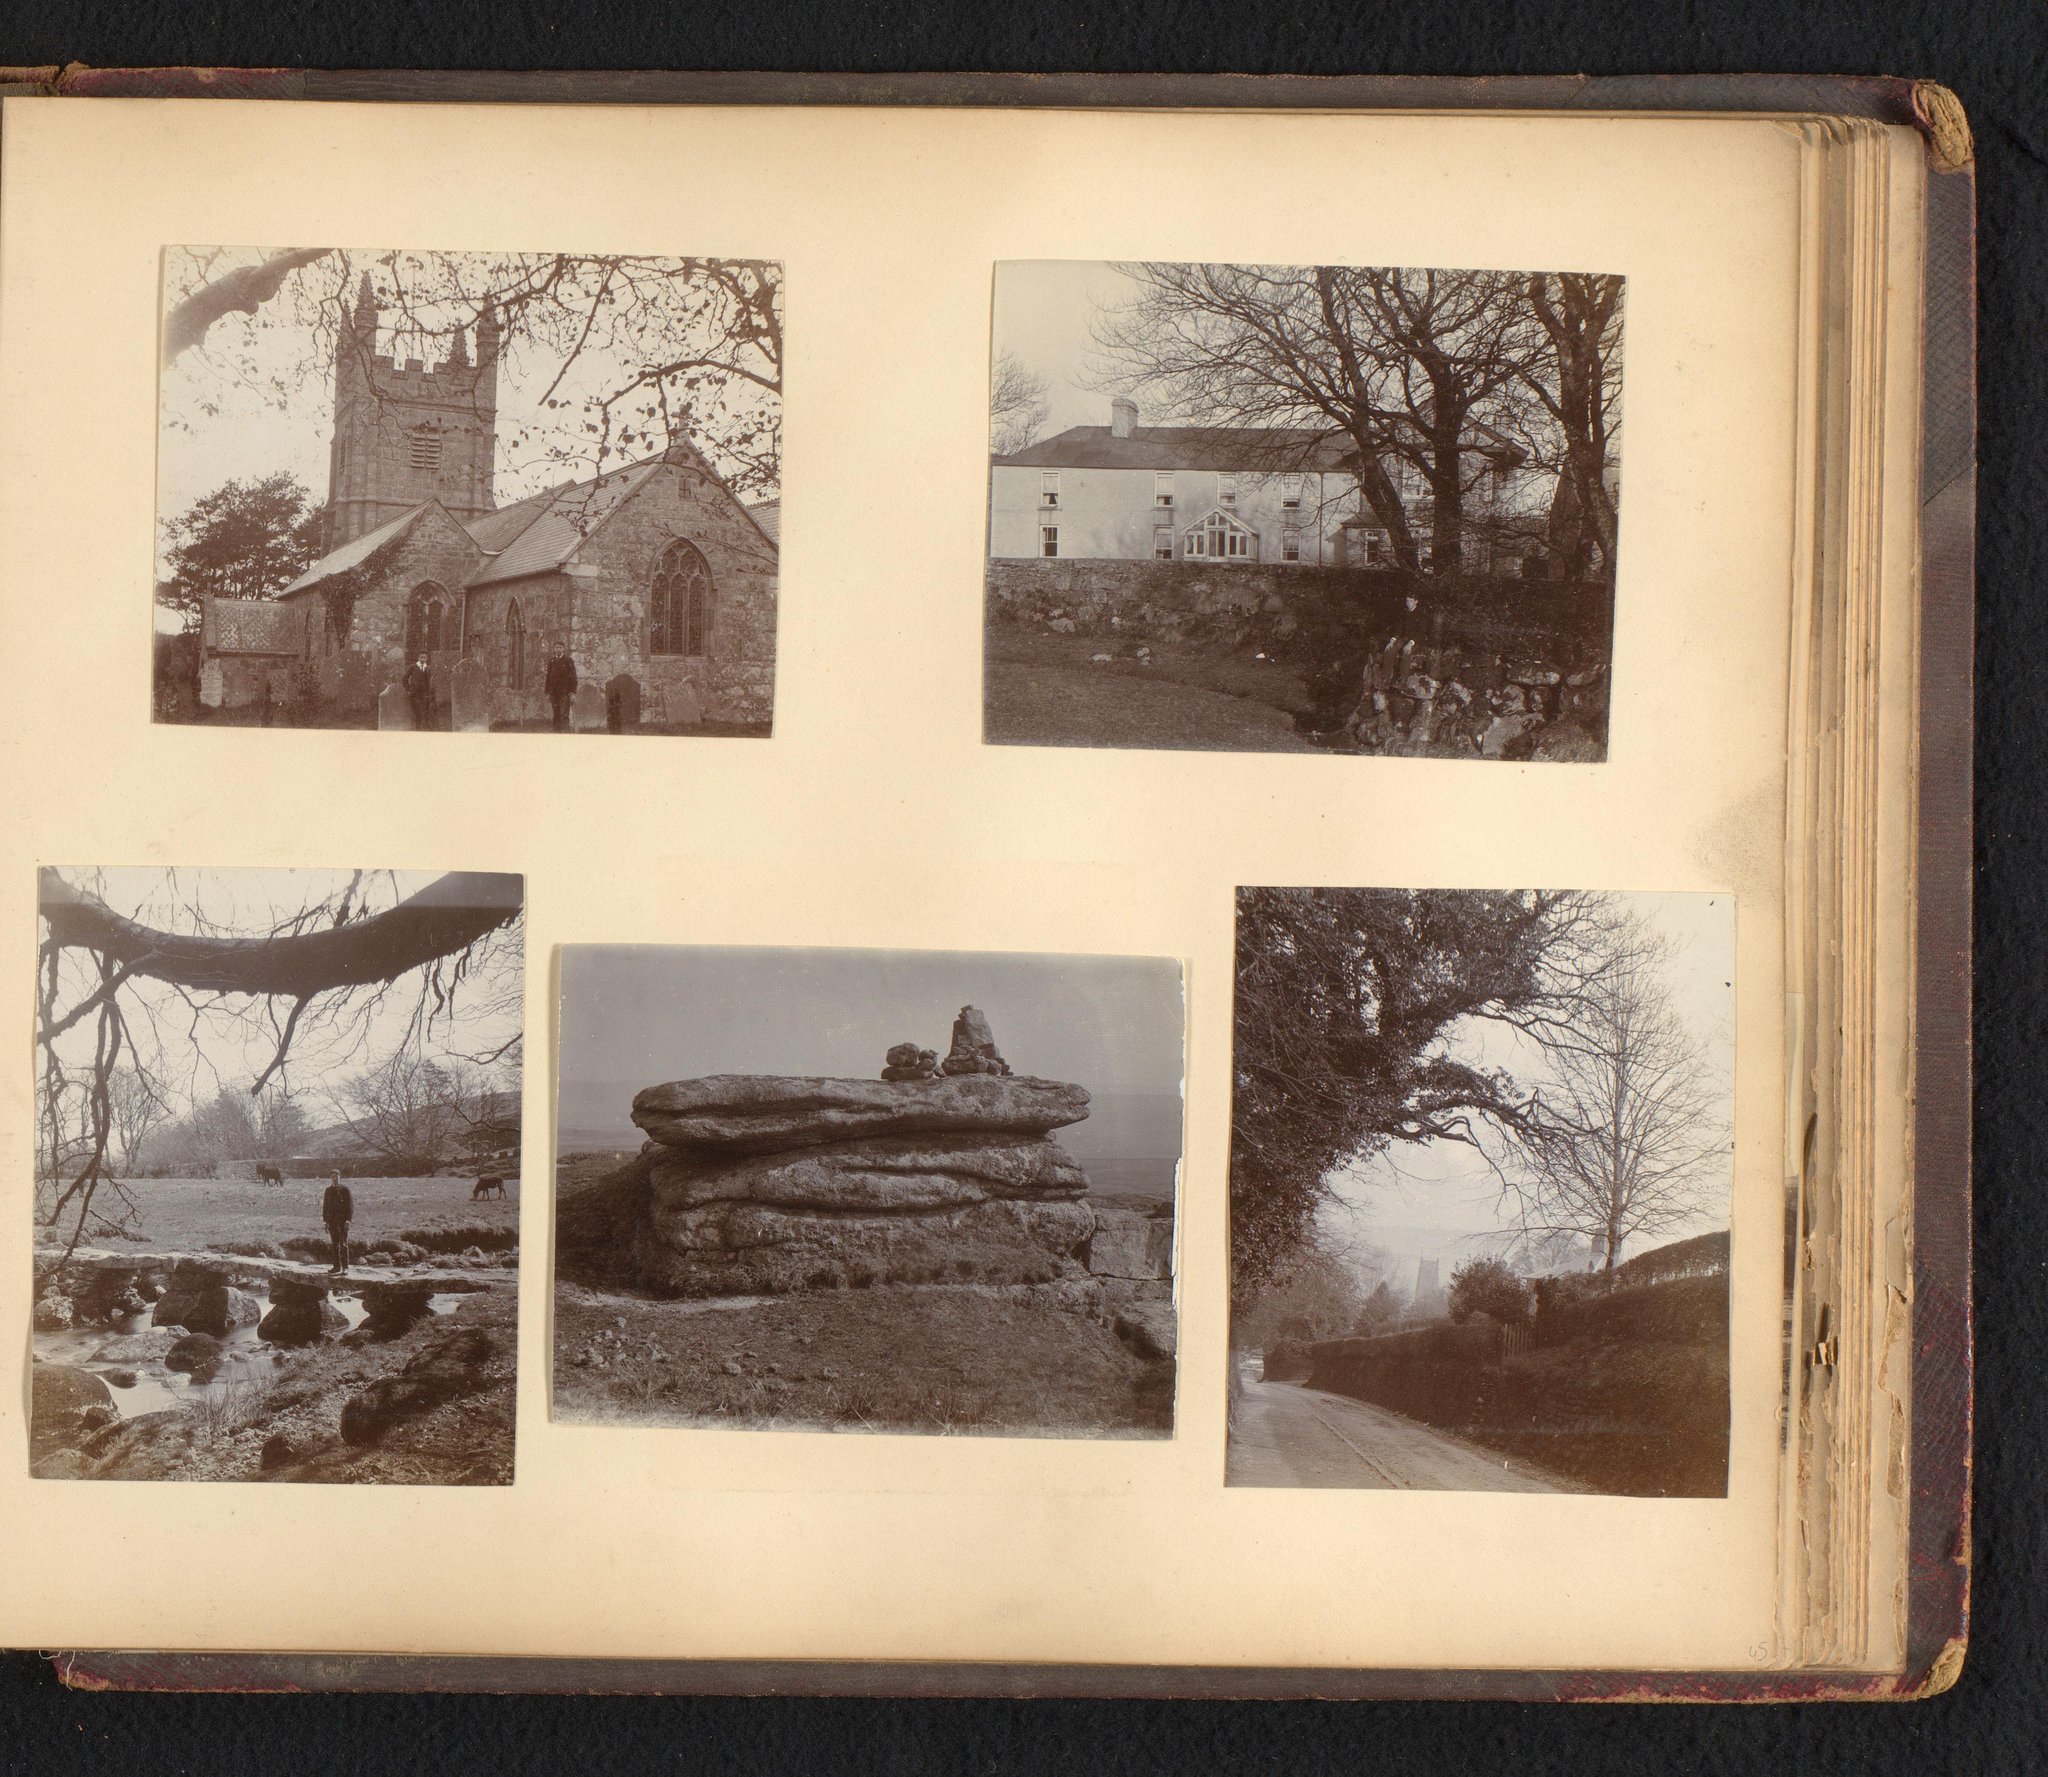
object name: photograph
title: Jongens in landschappen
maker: Anonymous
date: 1890-1898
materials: photographic support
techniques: gelatin silver print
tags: youth, adolescent, church (exterior), bridge, megalithic chambered tomb, dolmen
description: Jongens bij onder meer een kerk en een dolmen. Deze pagina maakt deel uit van een album.